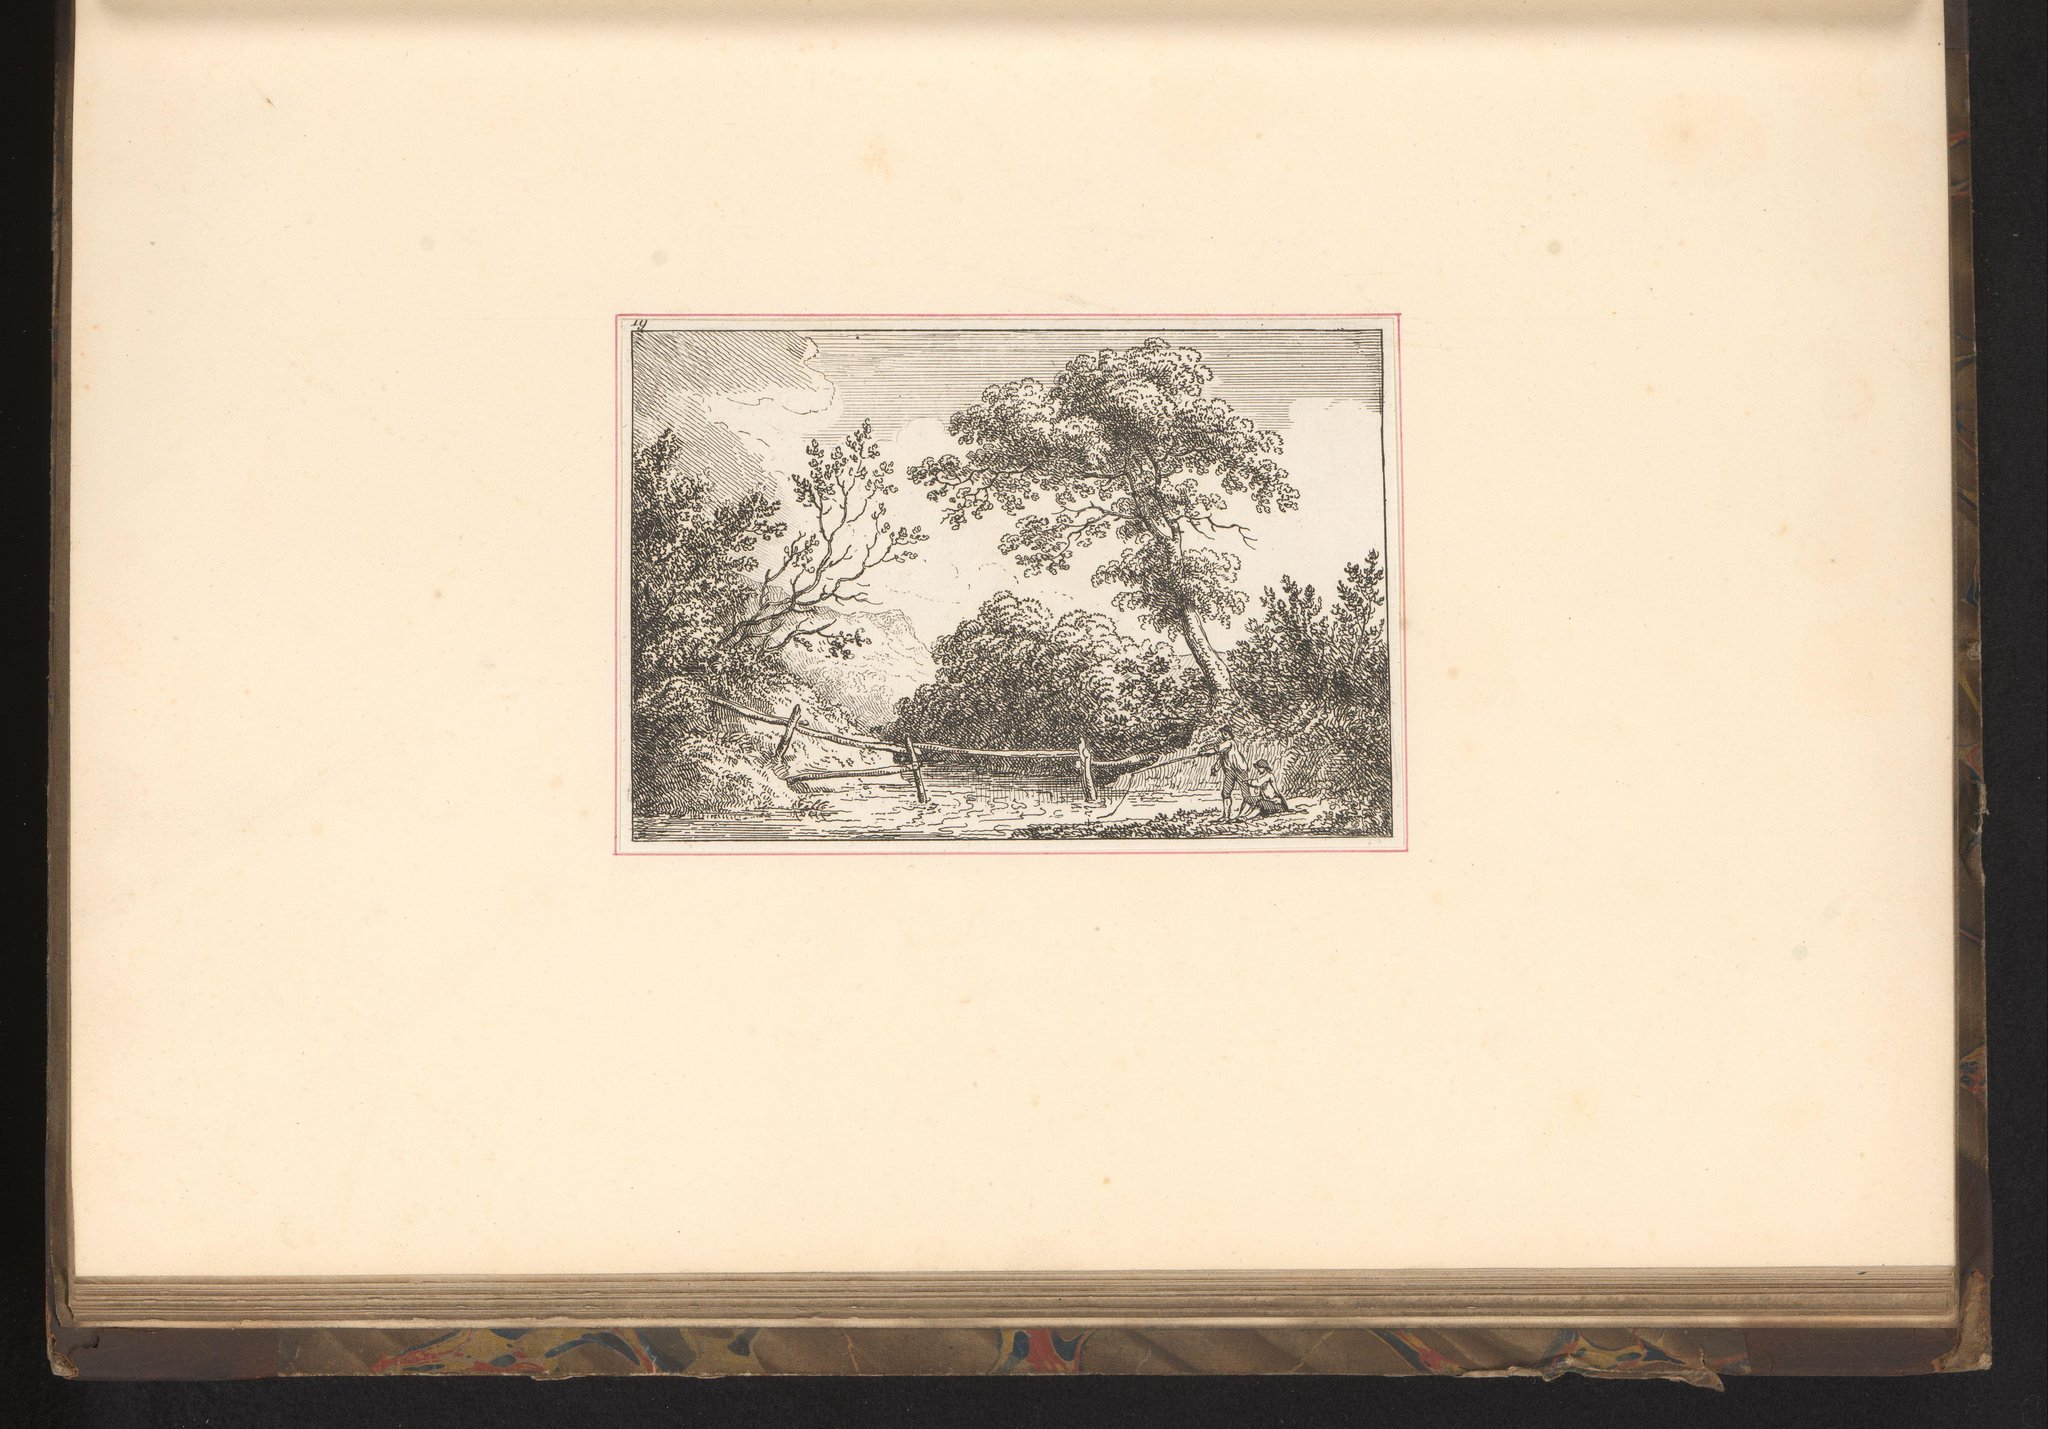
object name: print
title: Etchings by E. Edwards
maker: edward edwards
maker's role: painter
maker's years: 1738-1806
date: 1748-1806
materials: paper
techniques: etching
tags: river bank, landscapes (+ landscape with figures, staffage), fisherman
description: Prent maakt deel uit van een serie van 51 prenten, bestaande uit twee delen met landschappen (36 prenten) en figuren en portretten (15 prenten), voor het eerst uitgegeven in Londen in 1790.